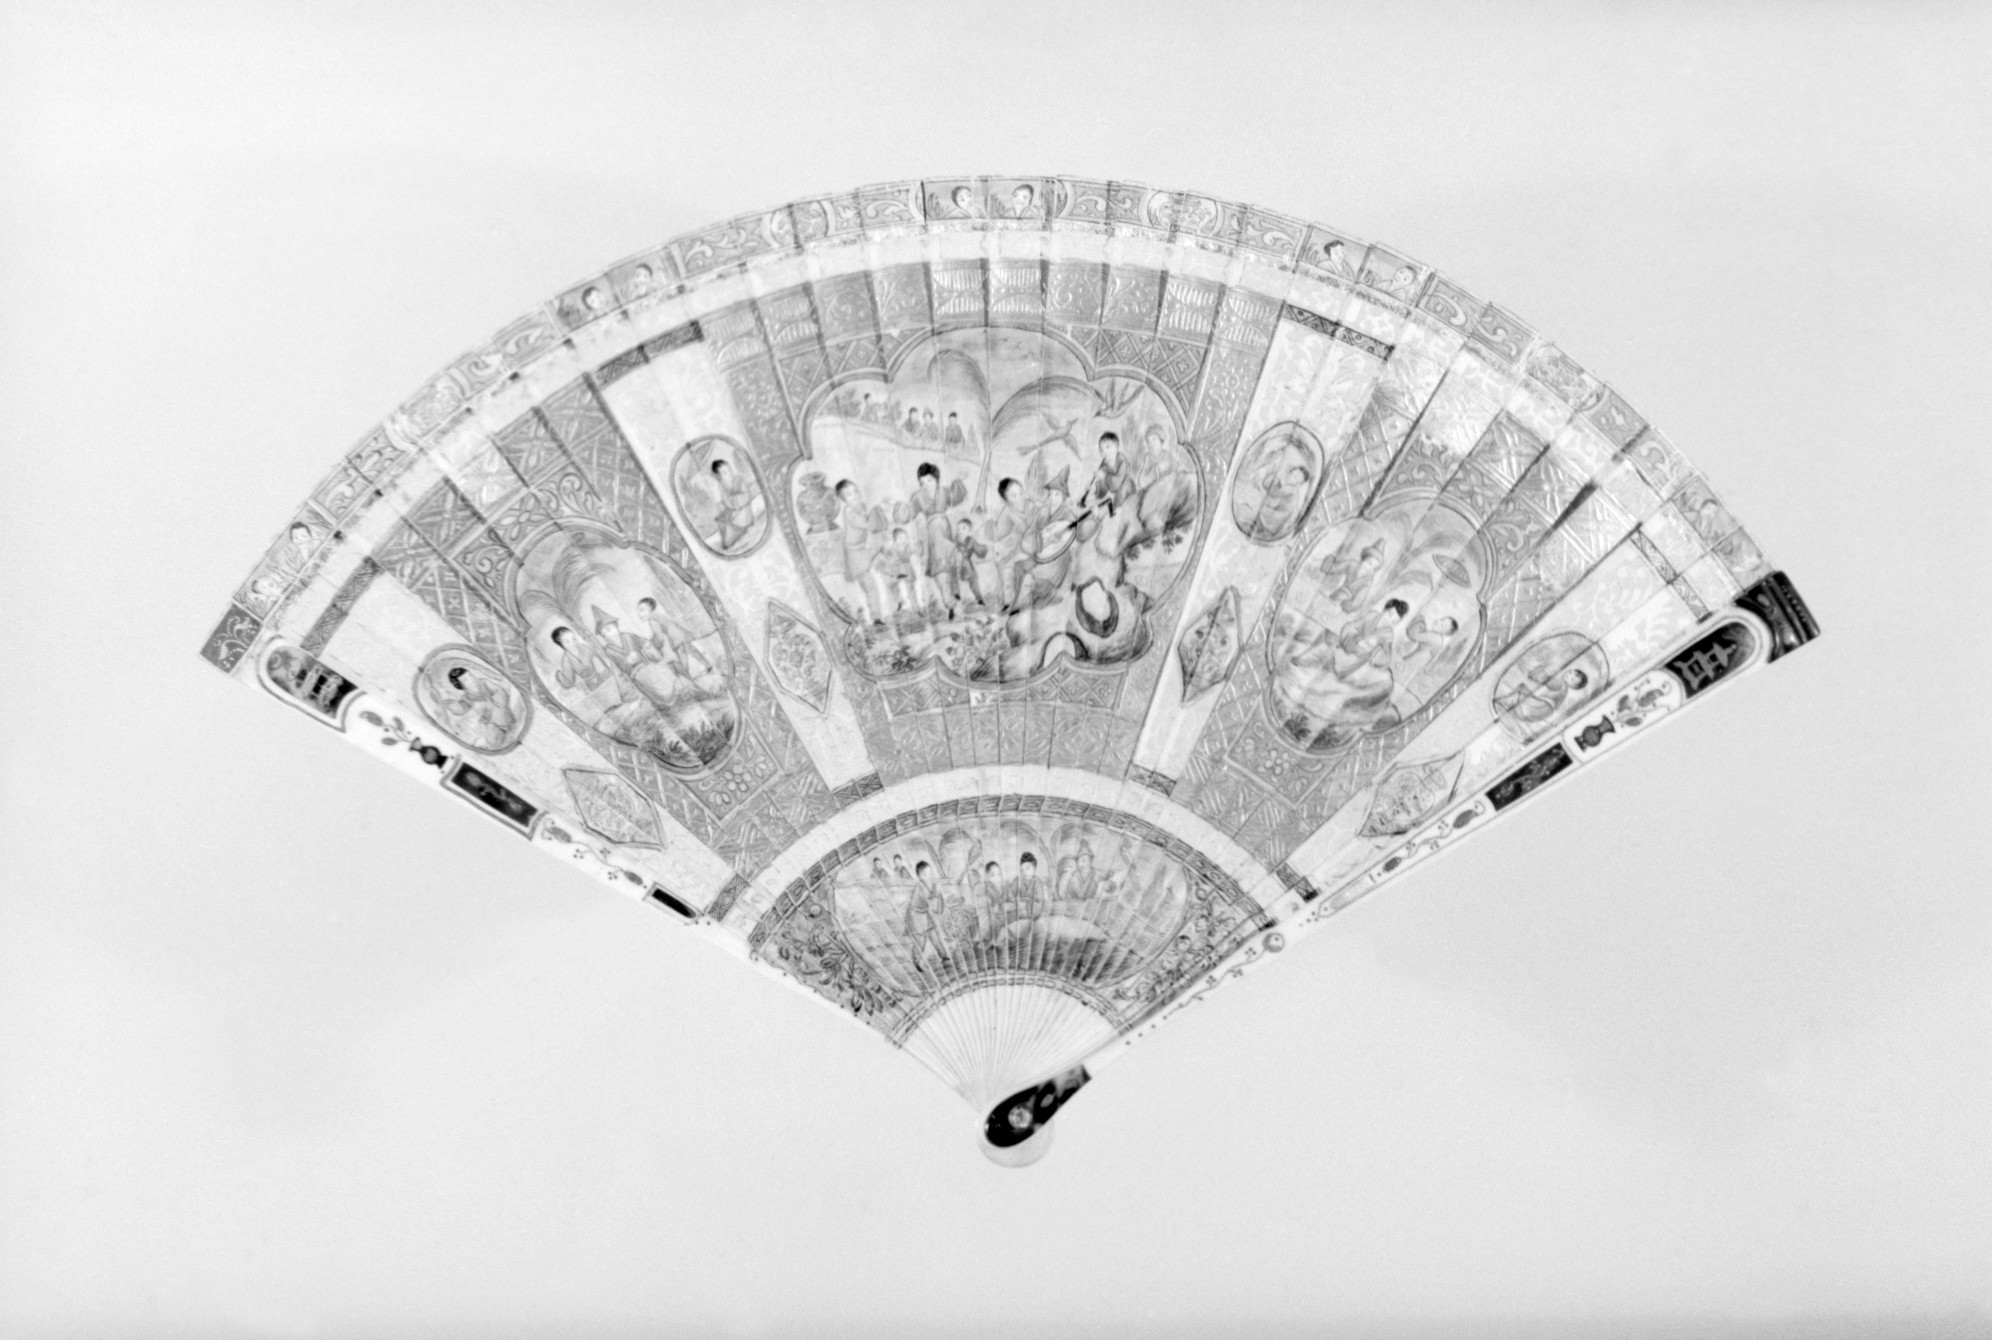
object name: fan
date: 1801-1833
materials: gilt, glass, ivory, metal, mother of pearl, paint, paper, shell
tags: birds,chinoiserie,men,lutes